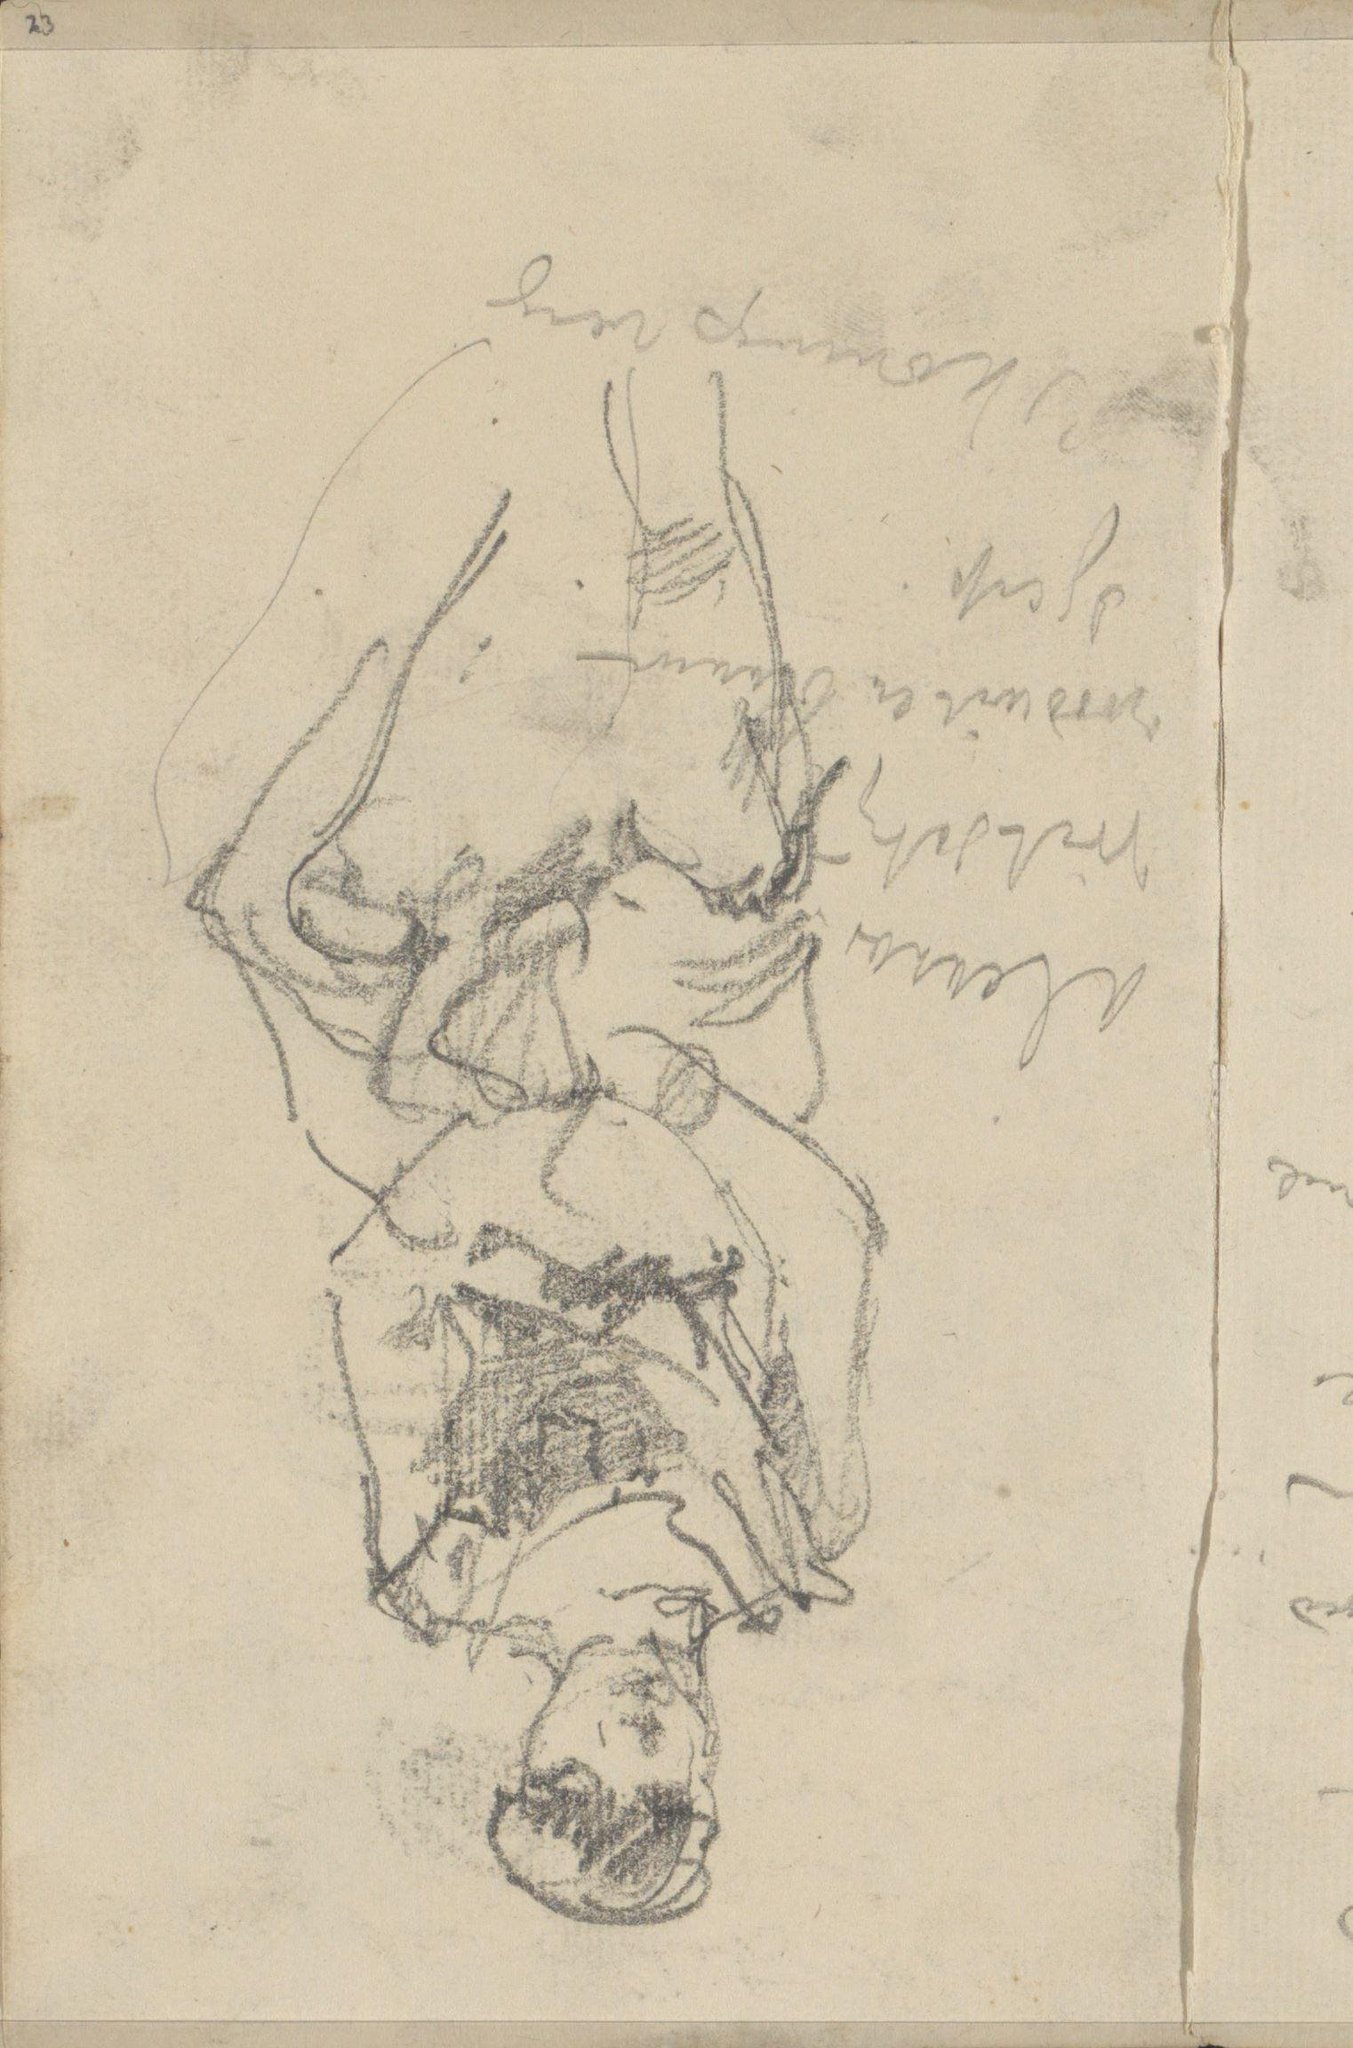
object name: sketchbook leaf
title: Zittende vrouw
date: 1882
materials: paper, pencil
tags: sitting figure - aa - female human figure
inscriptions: : ‘alcazar/ wit[...]/ rood wit en blauwe/ sjerp’, annotation: ‘'s Konings verf[?]’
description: Pagina 23 uit een schetsboek met 31 bladen vervaardigd te Den Haag en Rotterdam.